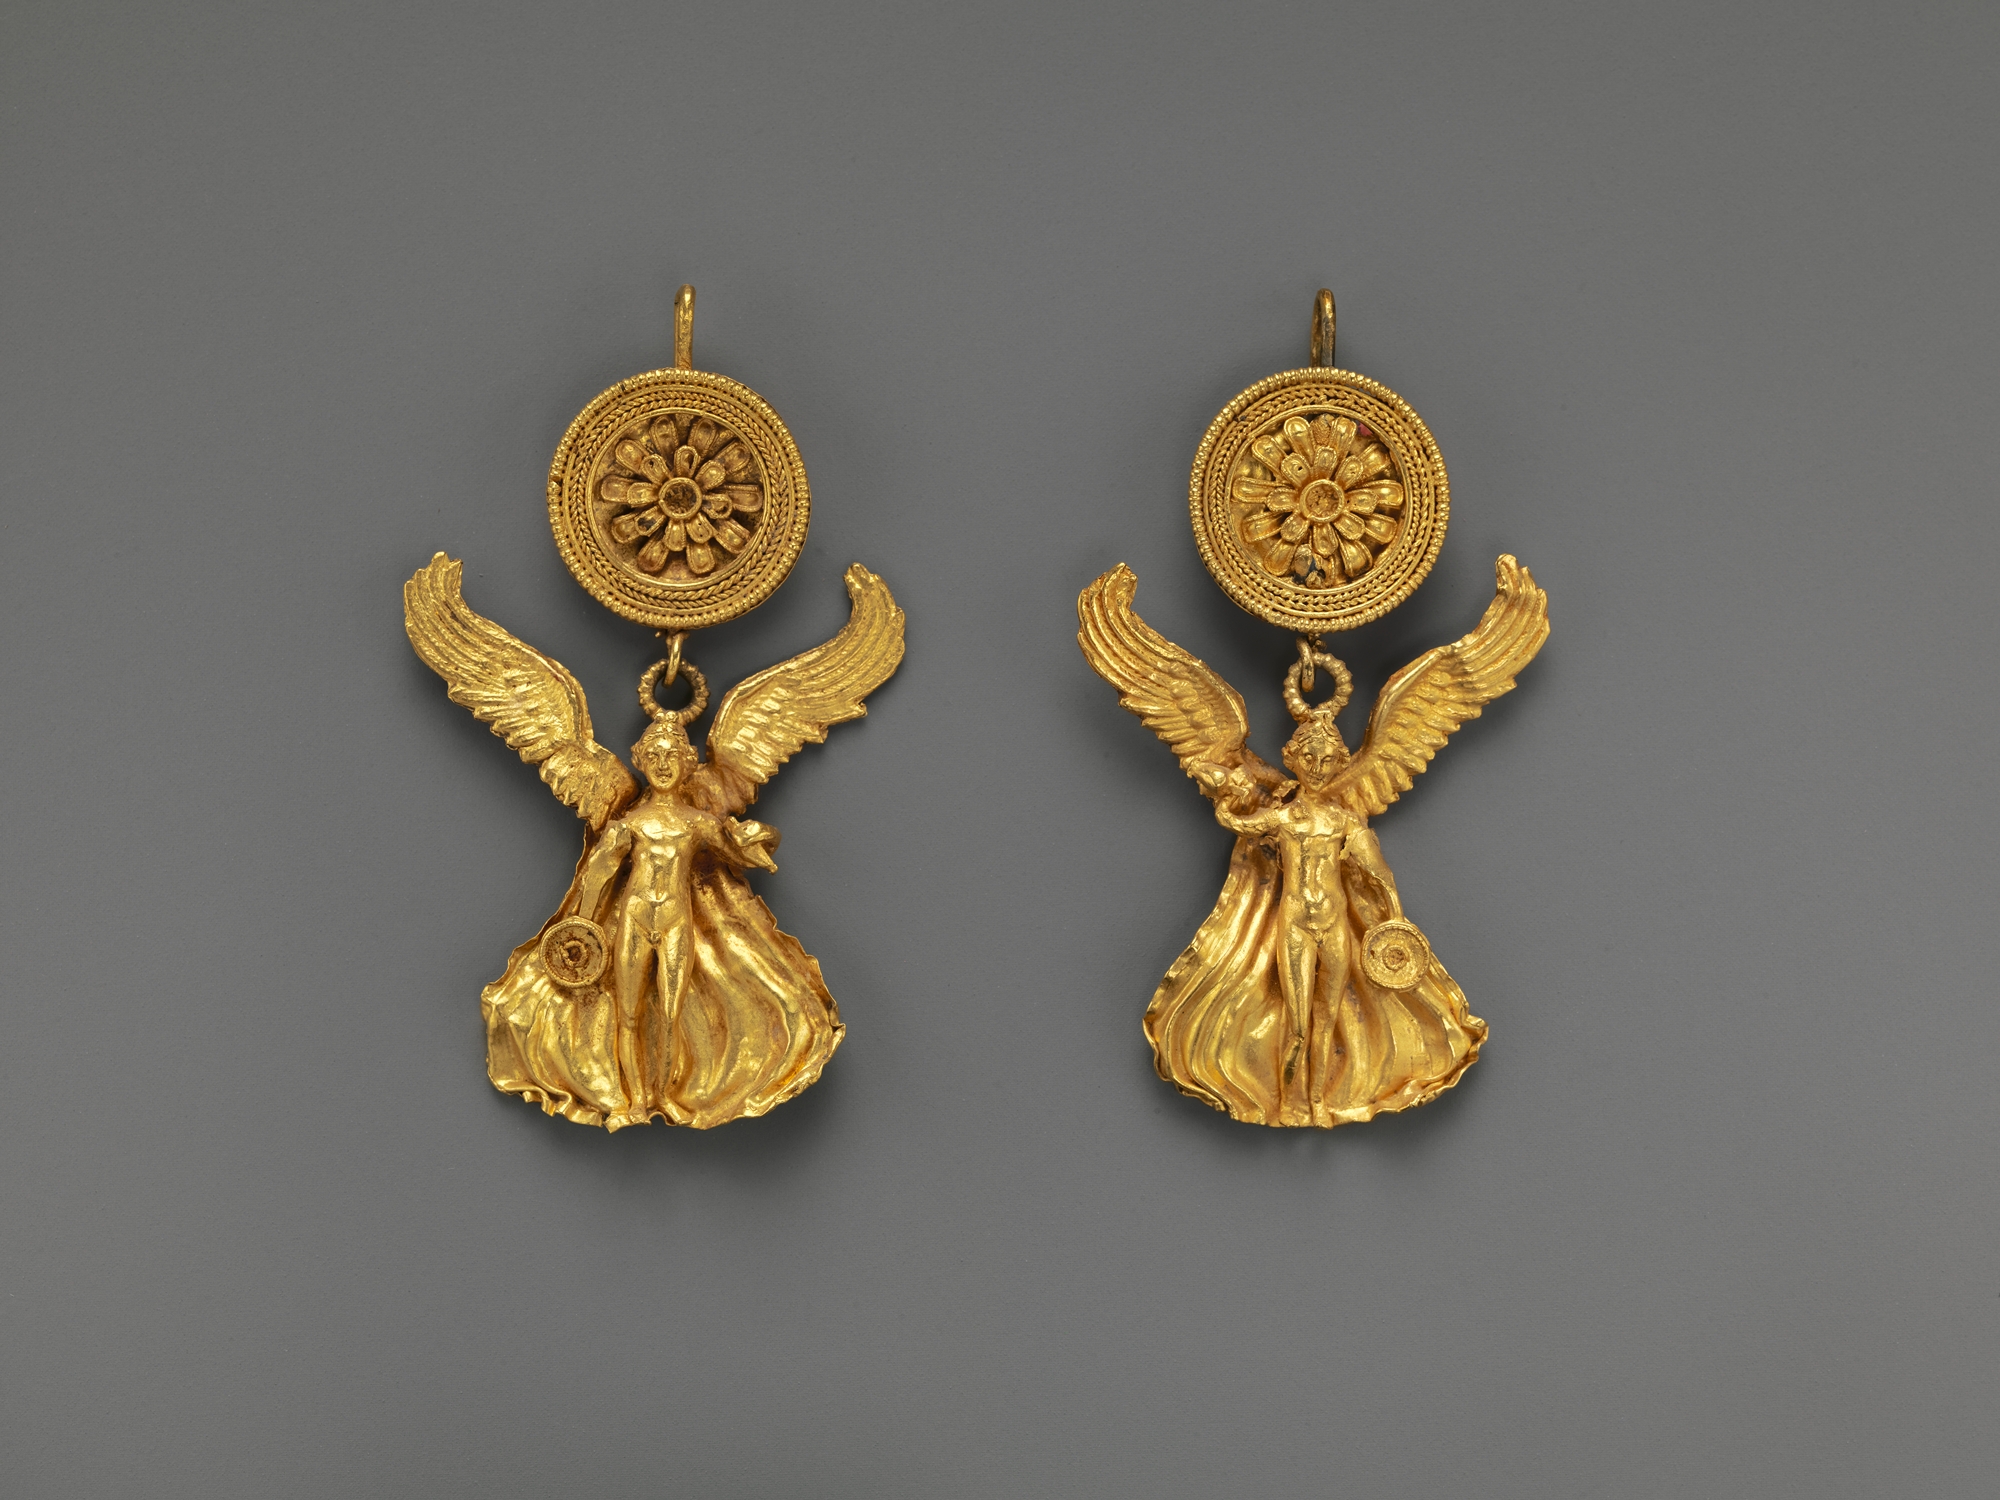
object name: earring with erotes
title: Pair of gold earrings with a disk and Eros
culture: greek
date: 300 BCE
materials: gold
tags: eros